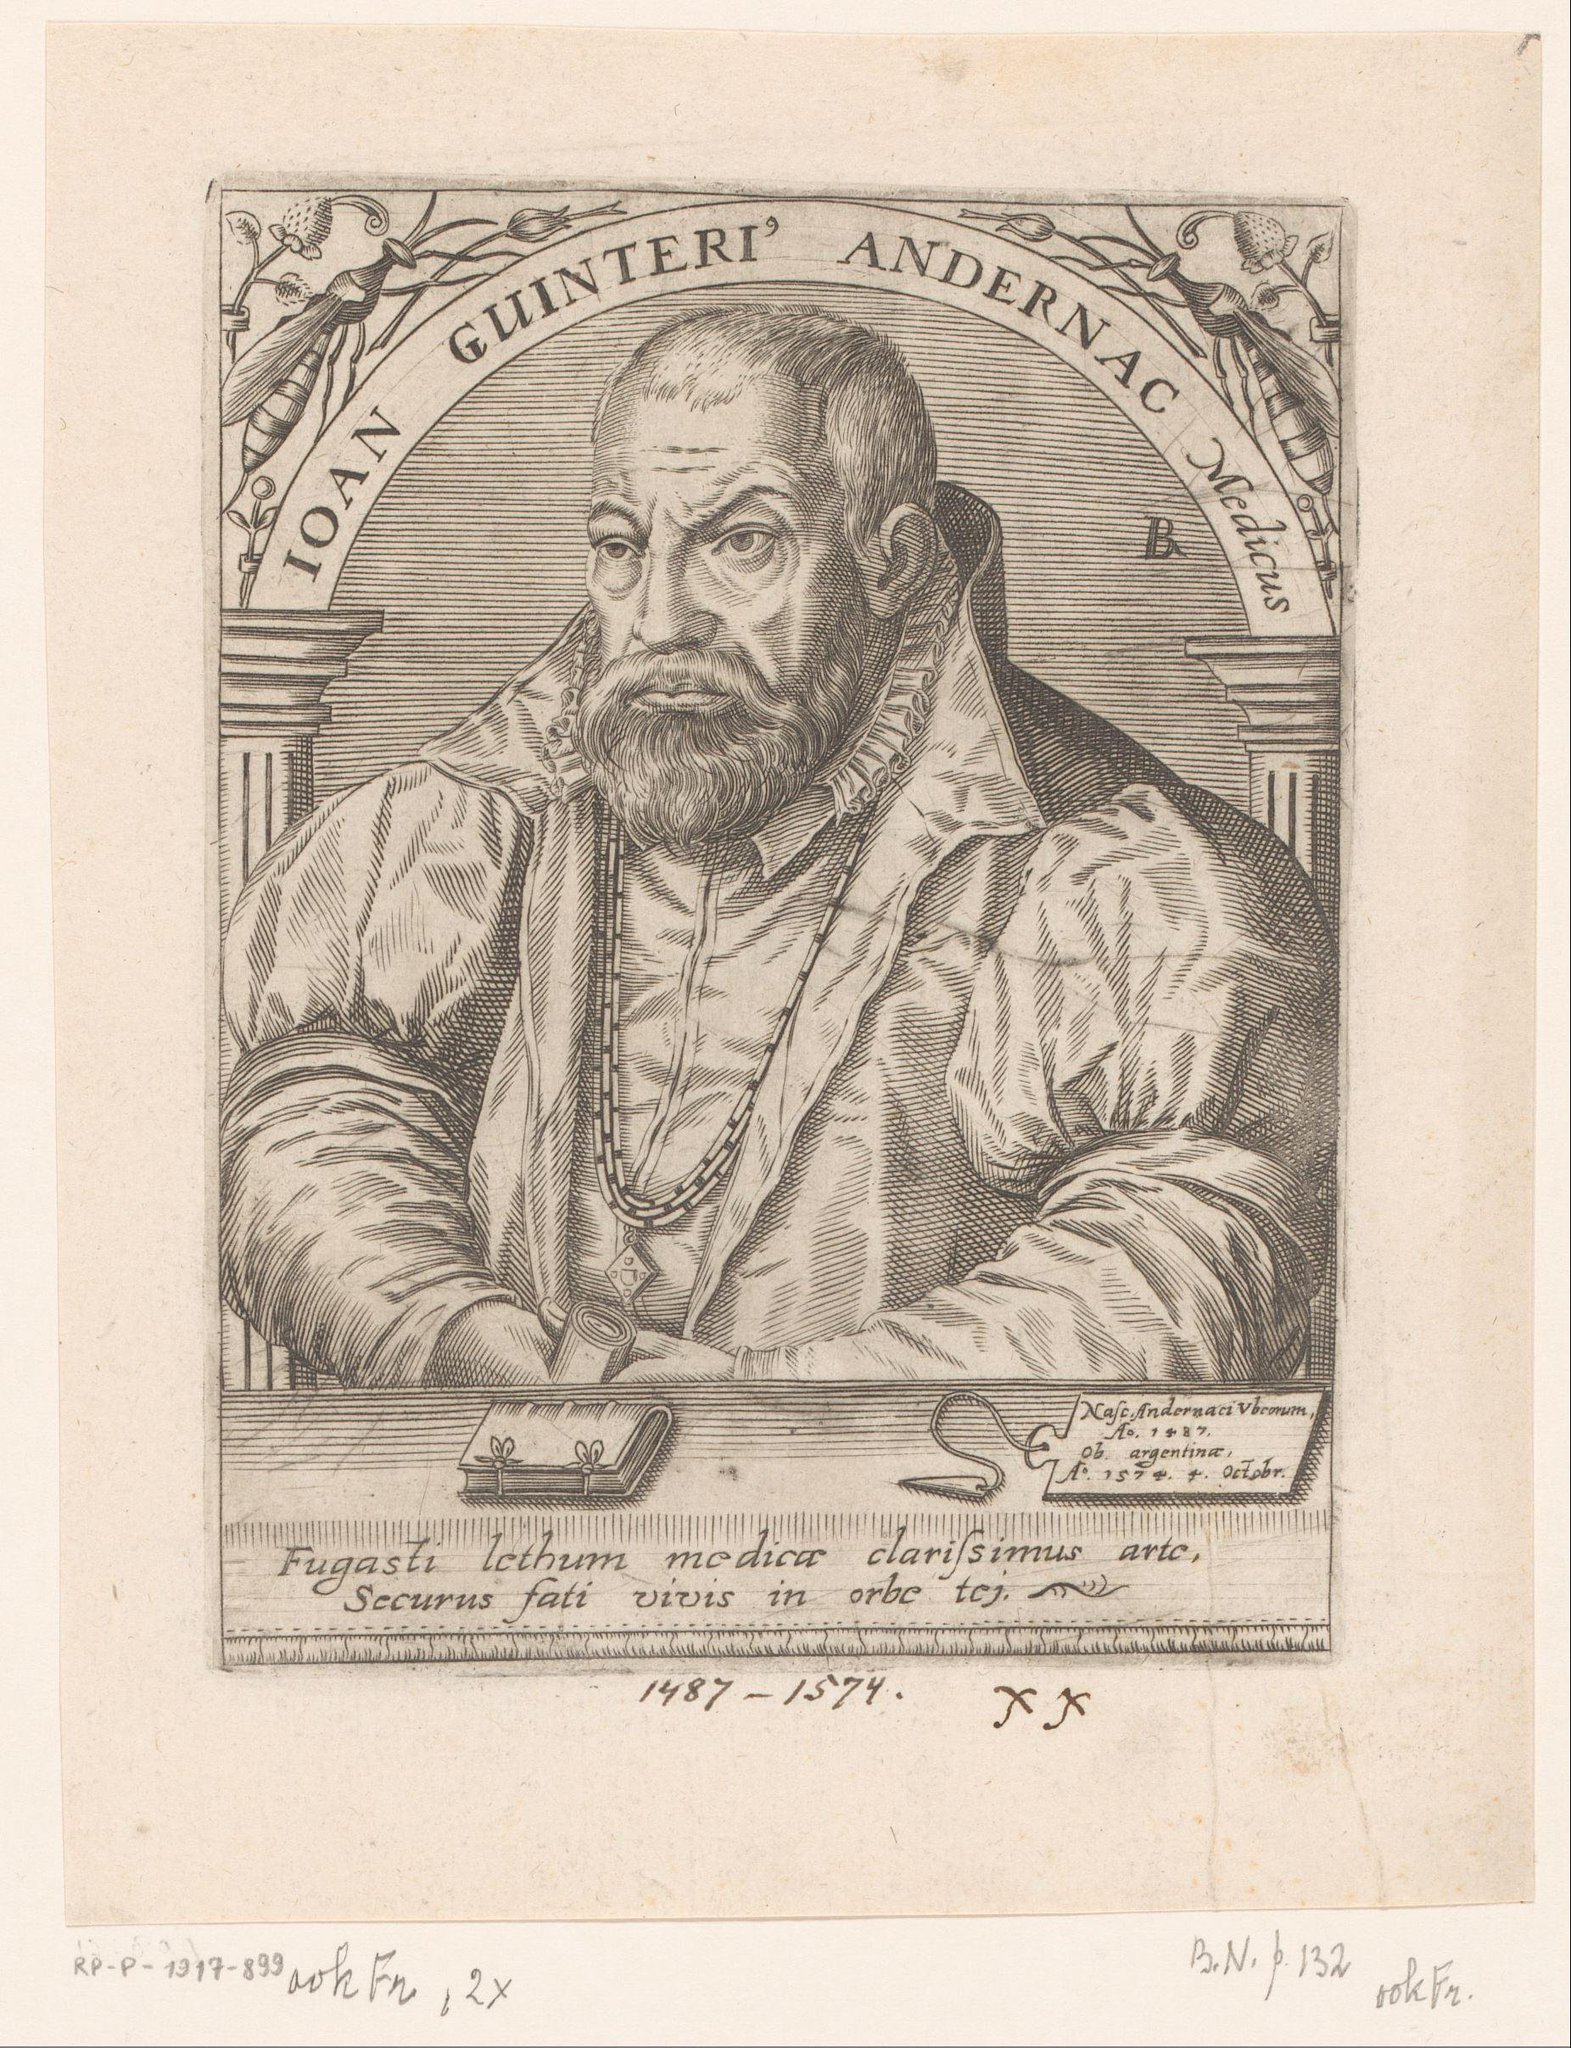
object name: print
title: Serie portretten van vijftiende- en zestiende-eeuwse geleerden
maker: robert boissard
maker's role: print maker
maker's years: 1570-1611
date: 1597-1599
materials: paper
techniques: engraving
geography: france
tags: historical persons, insects: wasp, book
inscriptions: collector's mark: Lugt 2228